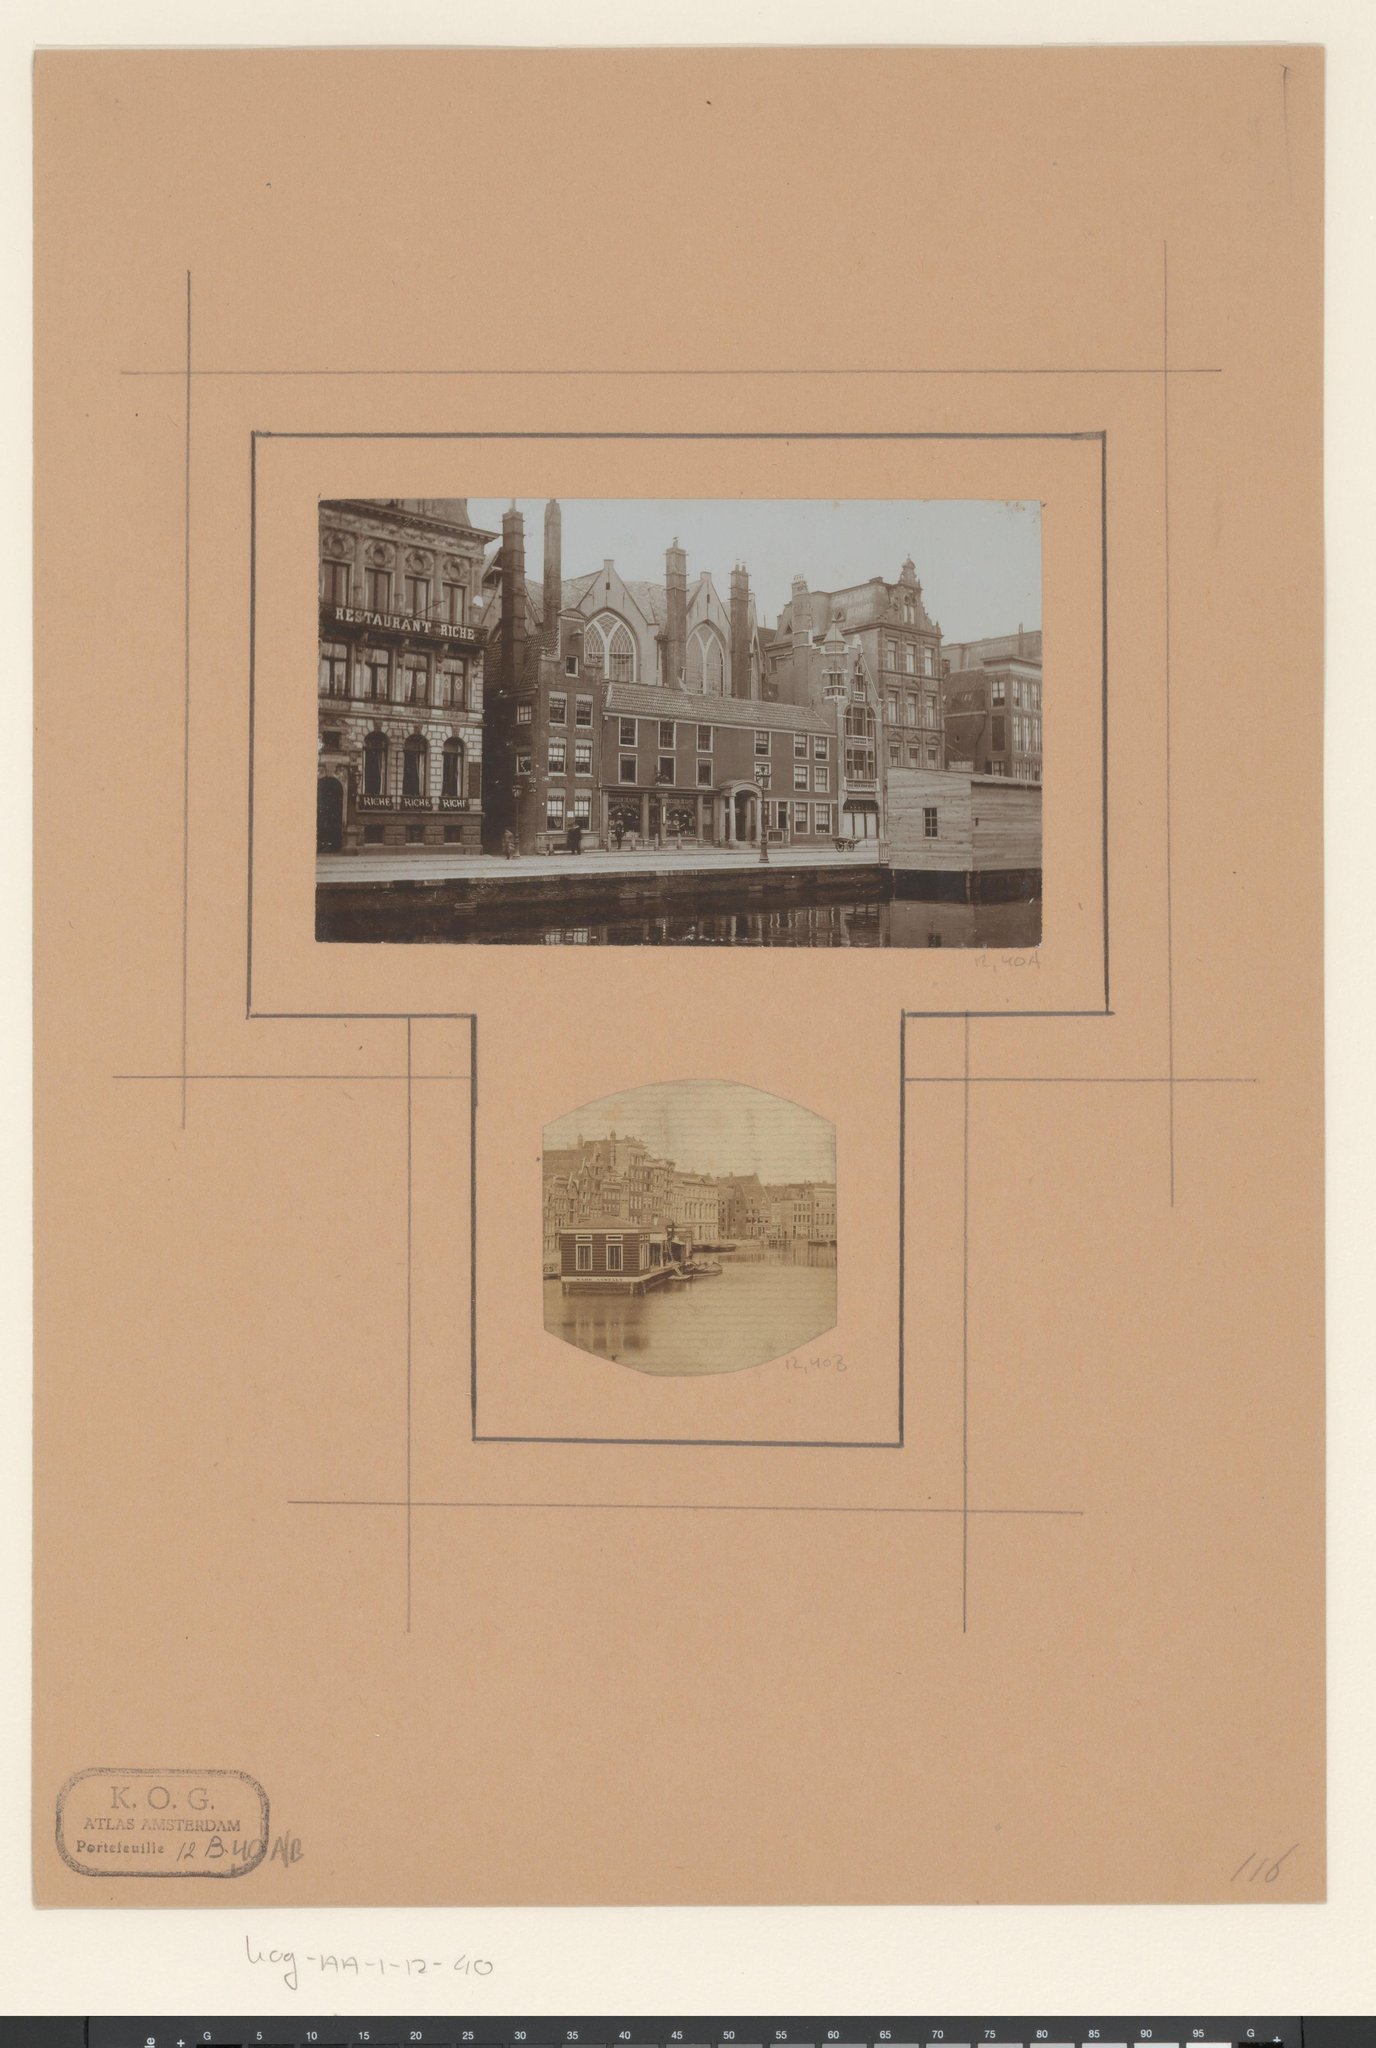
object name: photograph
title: Gezicht op de Nieuwezijds Kapel en het Rokin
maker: Anonymous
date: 1850-1915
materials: paper, cardboard, pencil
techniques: albumen print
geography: amsterdam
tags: parts of church exterior and annexes: chapel - qq - small church, chapel, city-view in general; 'veduta', canal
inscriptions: collector's mark: ‘12B 40 AB’ Lugt 1641b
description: Onderwerpsrubriek binnen de Atlas Amsterdam: Rokin, Rotterdammersloot, Rozengang, Rozengracht, Rozenstraat, Rusland, Rustenburgerstraat, Ruysdaelkade, Ruysdaelstraat, Ruyterkade (de), Ruyterweg (Admiraal de).